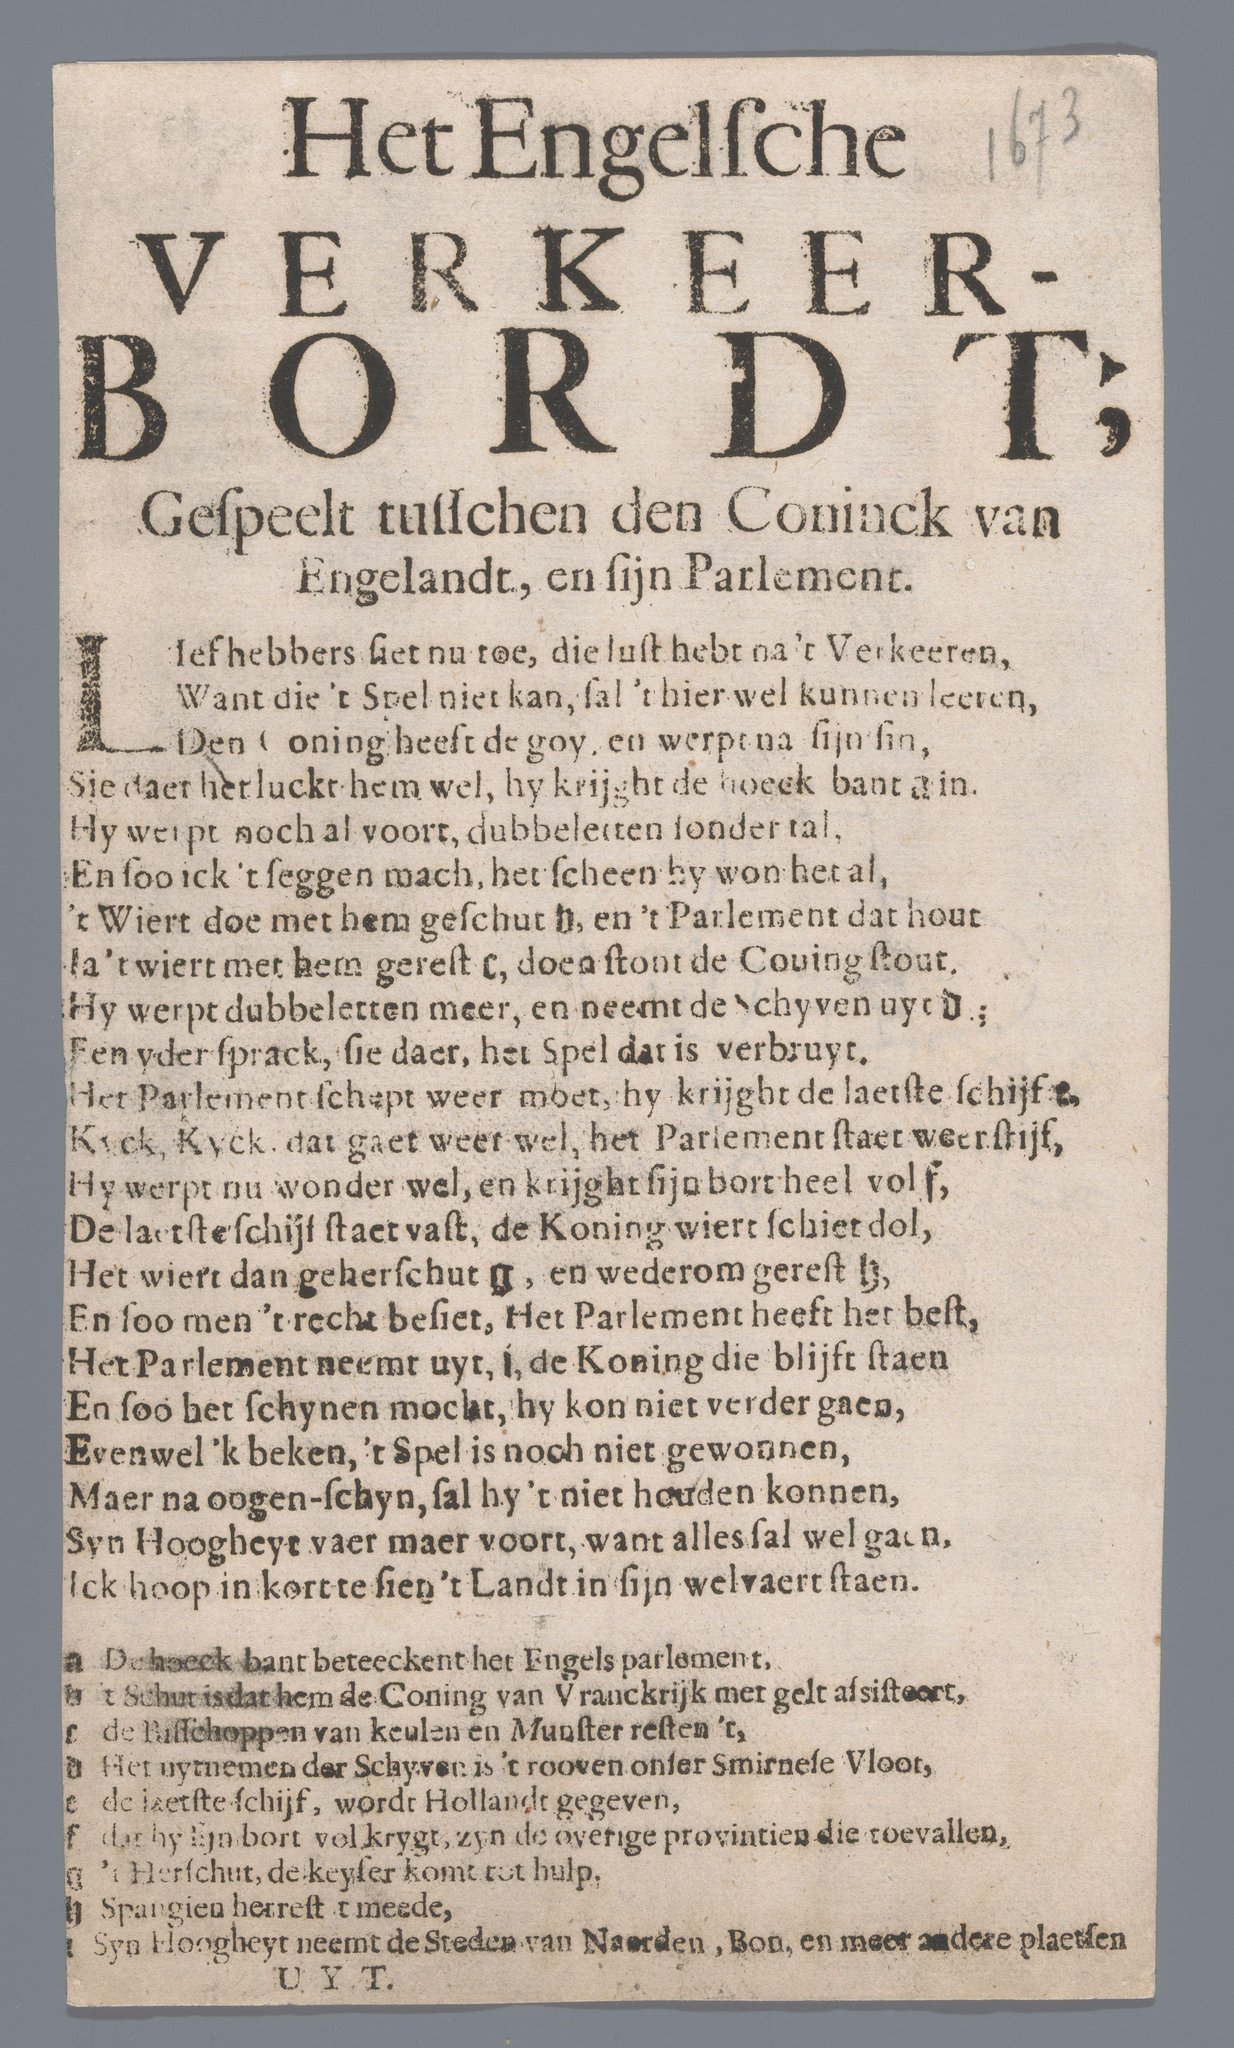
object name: pamphlet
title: Het Engelsche Verkeerbordt; Gespeelt tusschen den Coninck van Engelandt, en sijn Parlement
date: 1673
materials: paper, pencil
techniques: printing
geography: netherlands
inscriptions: date